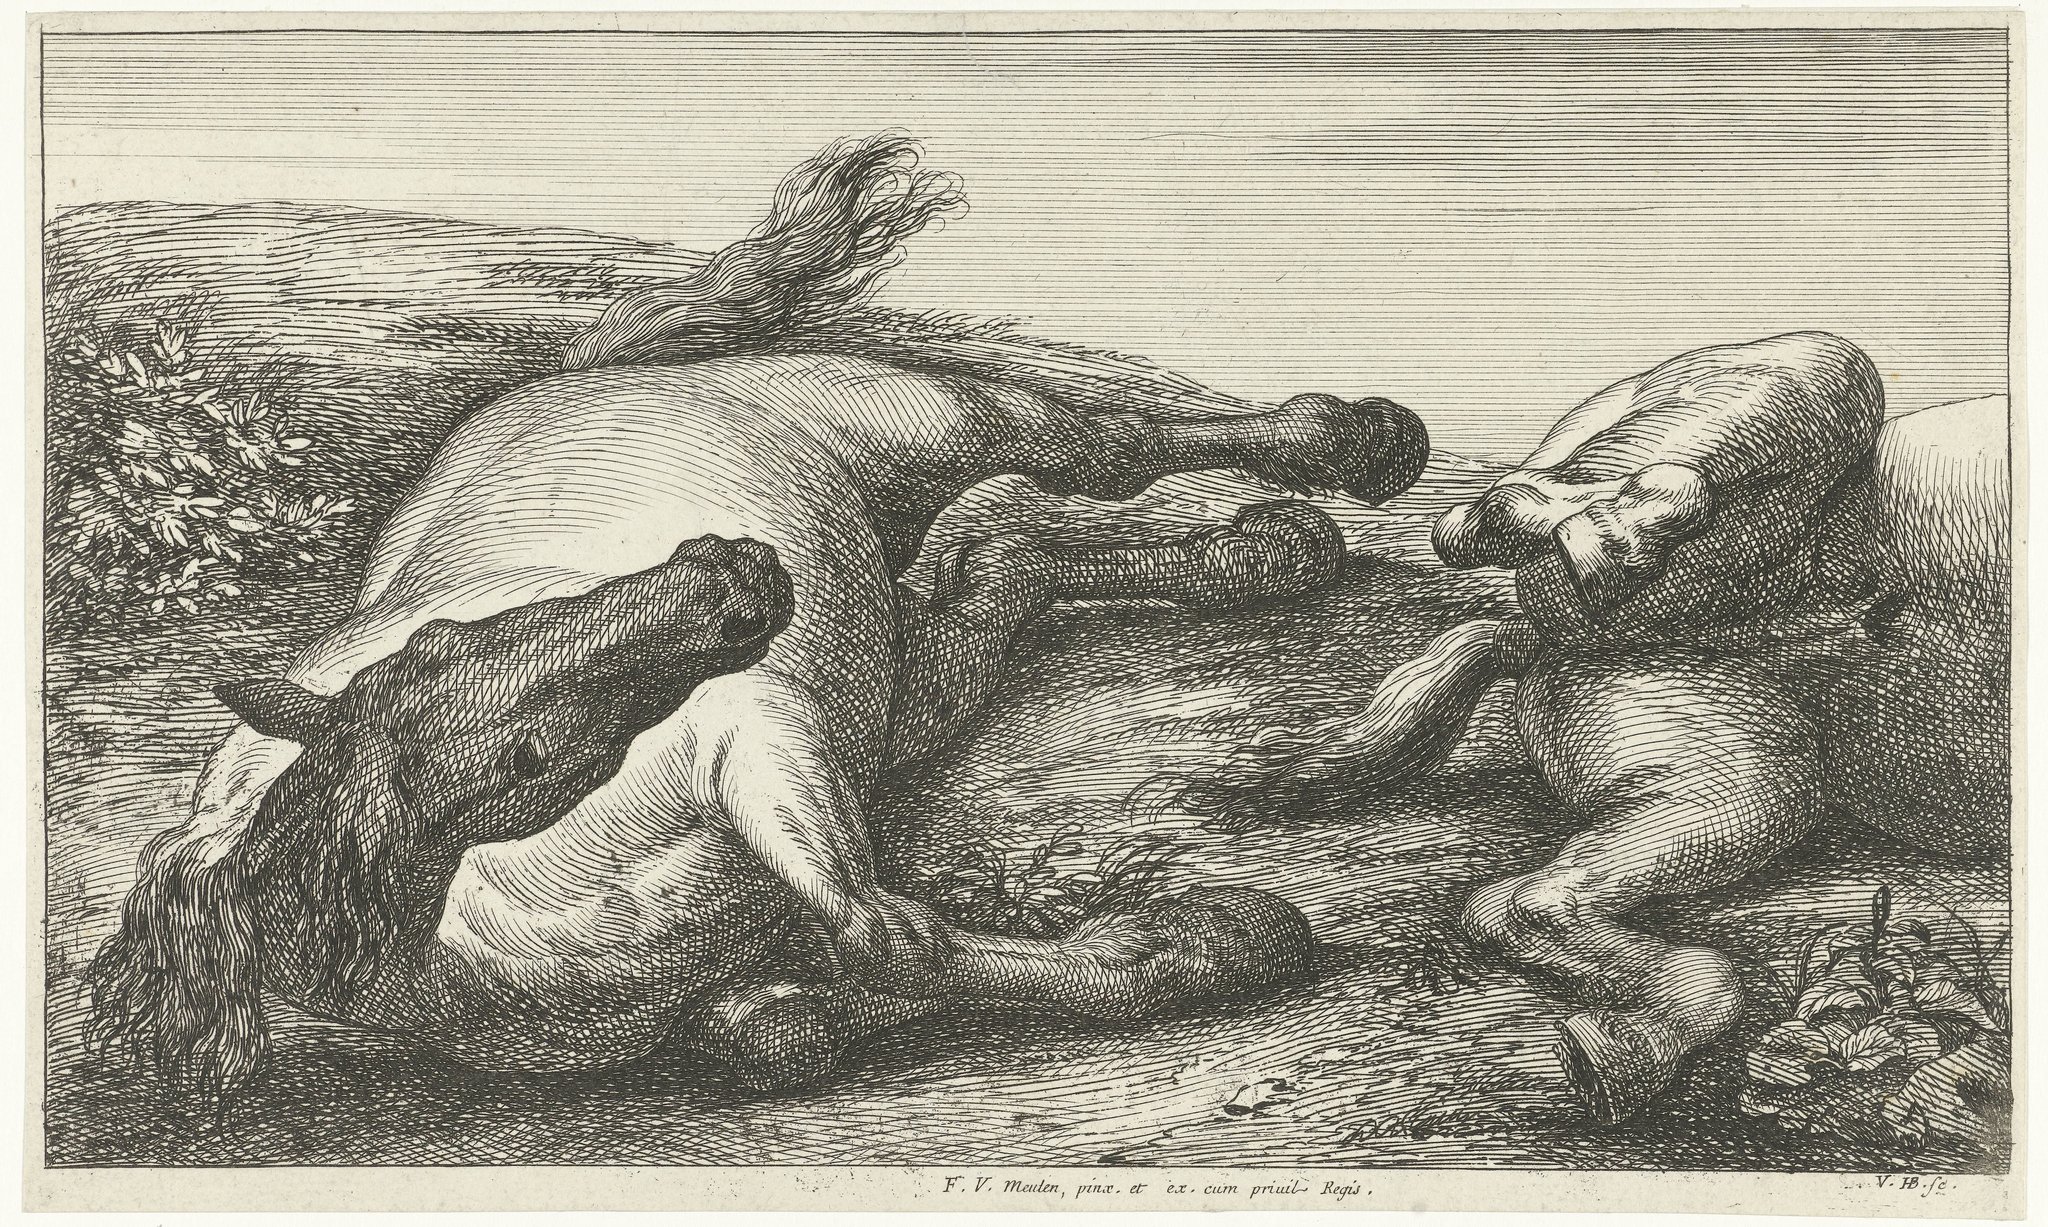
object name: print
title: Gesneuvelde paarden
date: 1674-1733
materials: paper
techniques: engraving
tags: horse (+ dying animal; death of animal; dead animal)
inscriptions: collector's mark: Lugt 2228, inscription: ‘Namly 1770’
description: Links een op de rechterzij liggend paard van voren gezien. Rechts de achterkant van een liggend paard op de buik gezien.